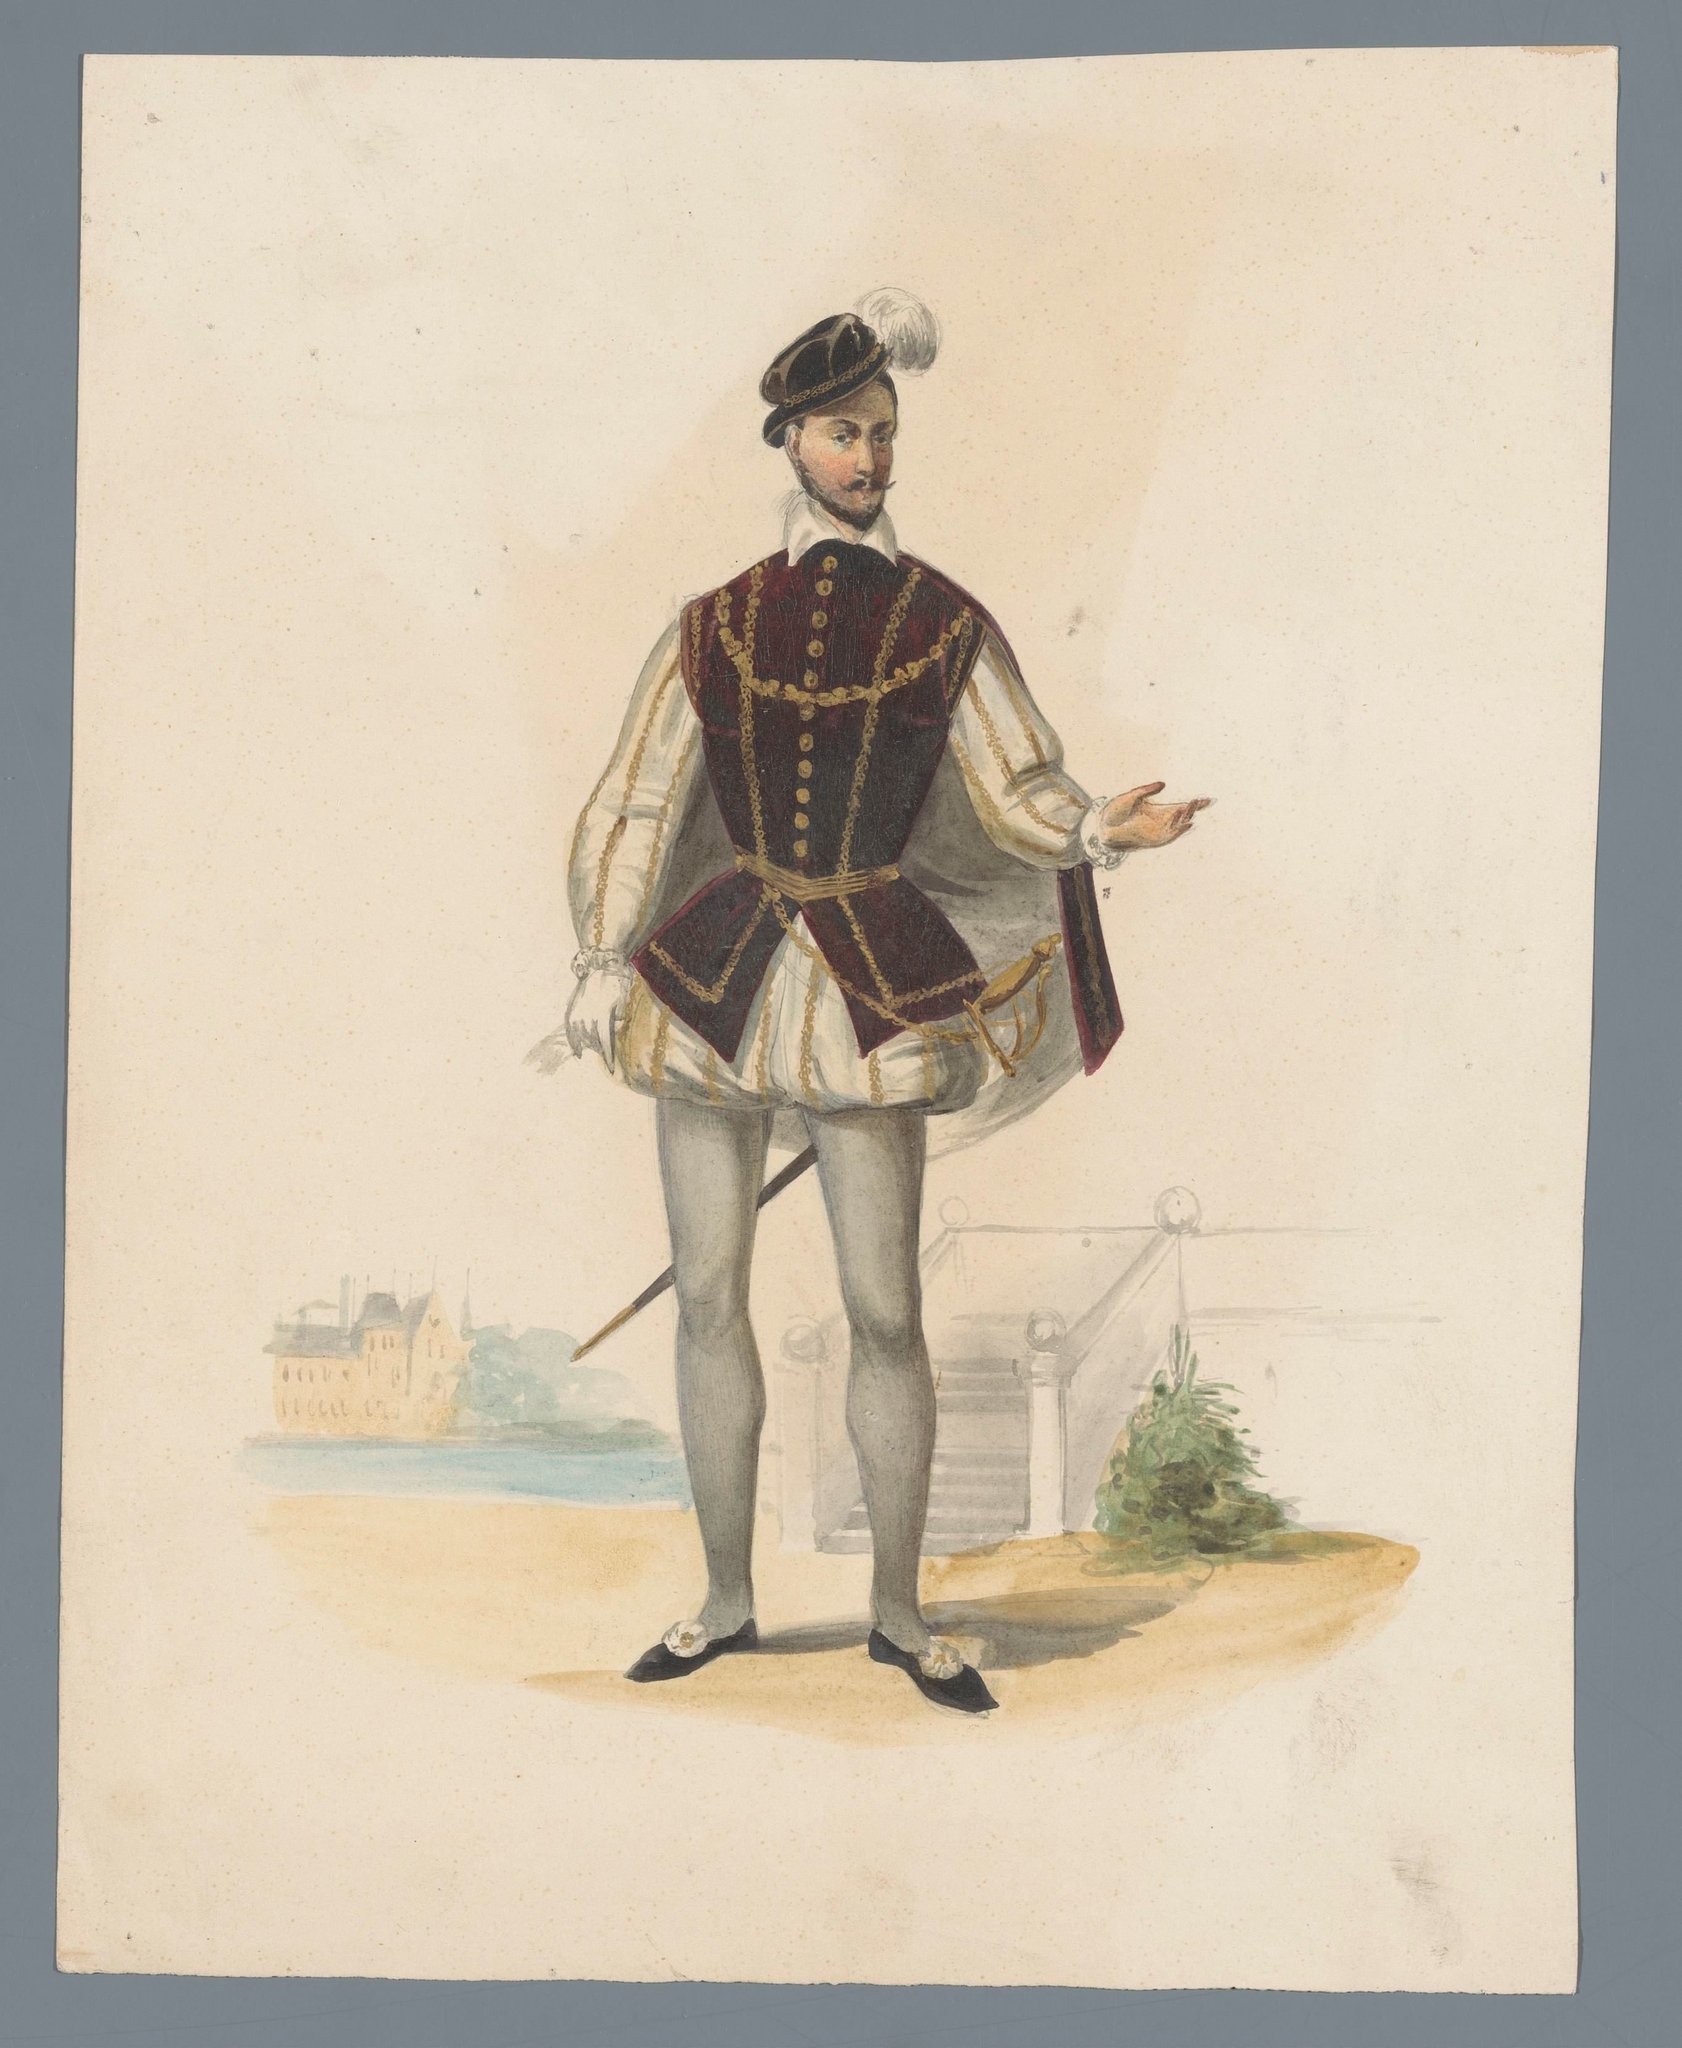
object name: drawing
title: Kostuumprent van een edelman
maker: Anonymous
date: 1840-1850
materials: lacquer, paper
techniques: lacquer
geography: netherlands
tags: historical costume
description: Man in historisch kostuum, 16e eeuw. Voorstelling toegevoegd aan het plaatwerk over het gekostumeerd bal gehouden op het paleis van de prins van Oranje (de latere koning Willem III) in Den Haag op 26 februari 1845.